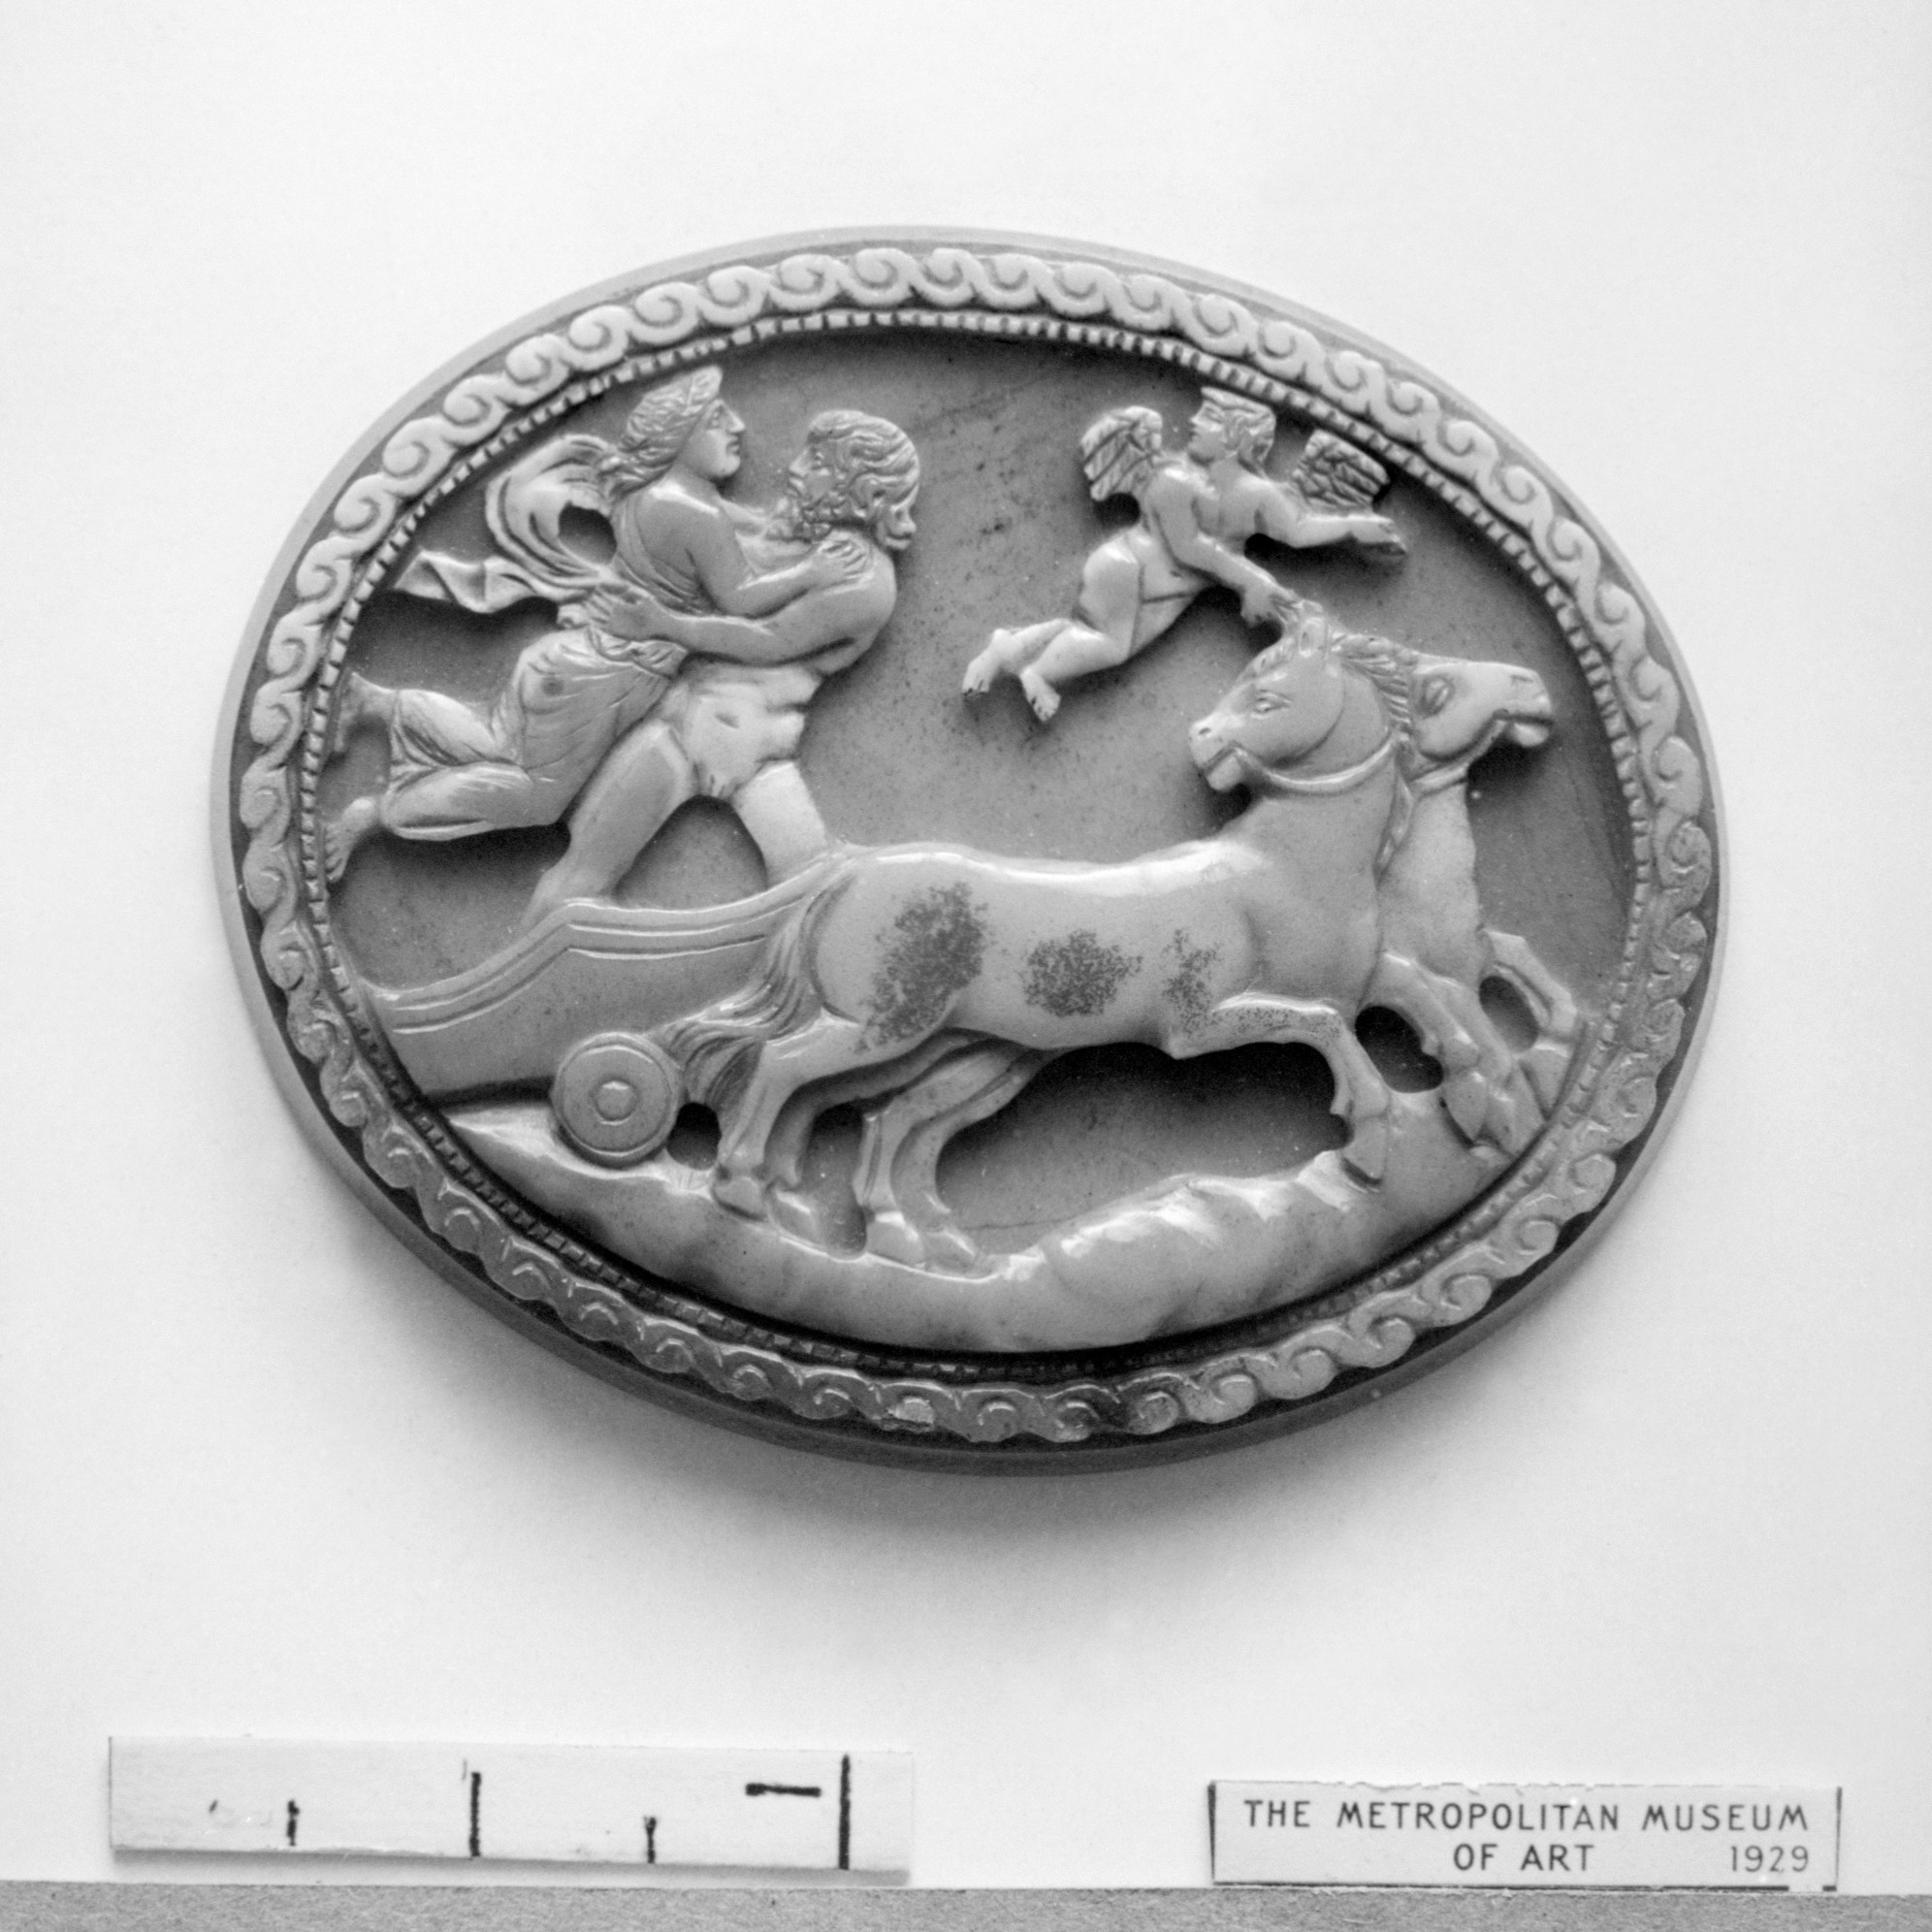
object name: cameo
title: Abduction of Proserpine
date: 1601-1700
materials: gemstone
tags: men,male nudes,women,putti,horses